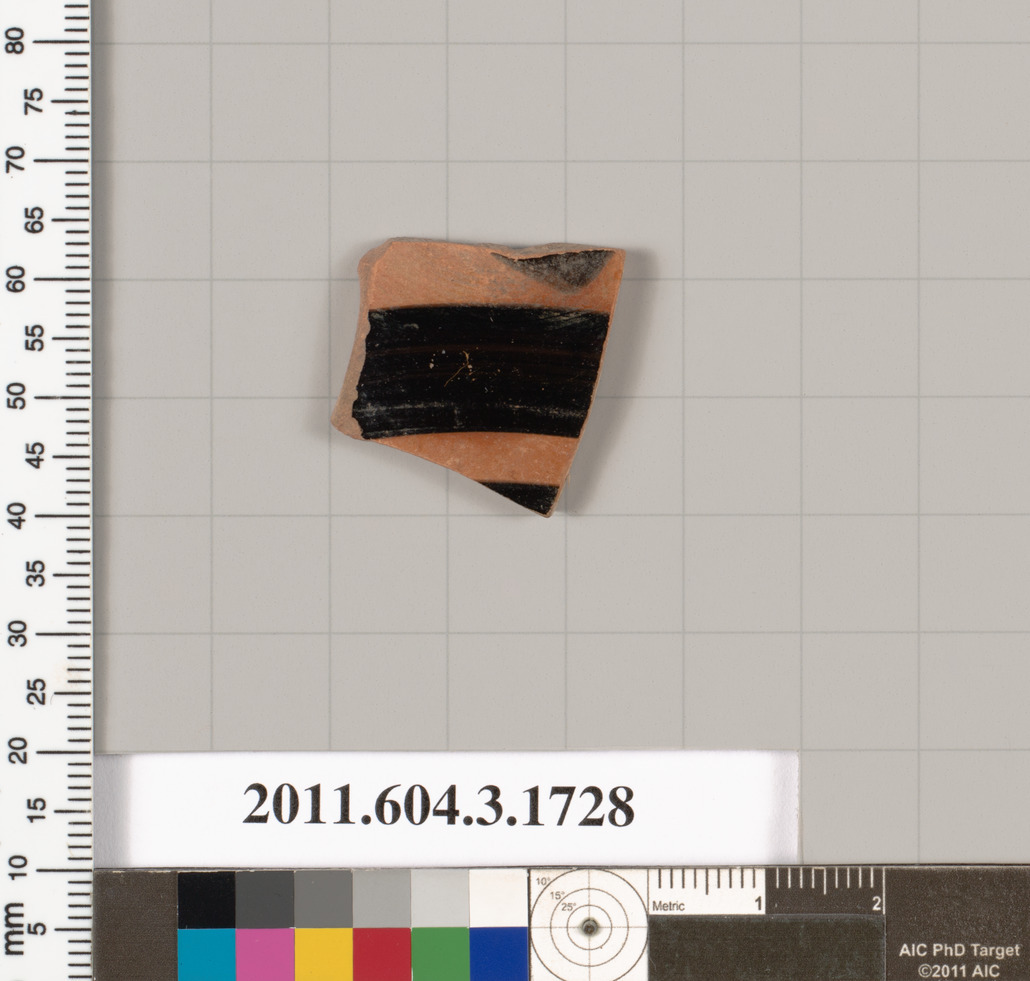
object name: kylix fragment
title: Terracotta fragment of a kylix: Band or lip cup (drinking cup)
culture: greek, attic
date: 550-526 BCE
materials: terracotta